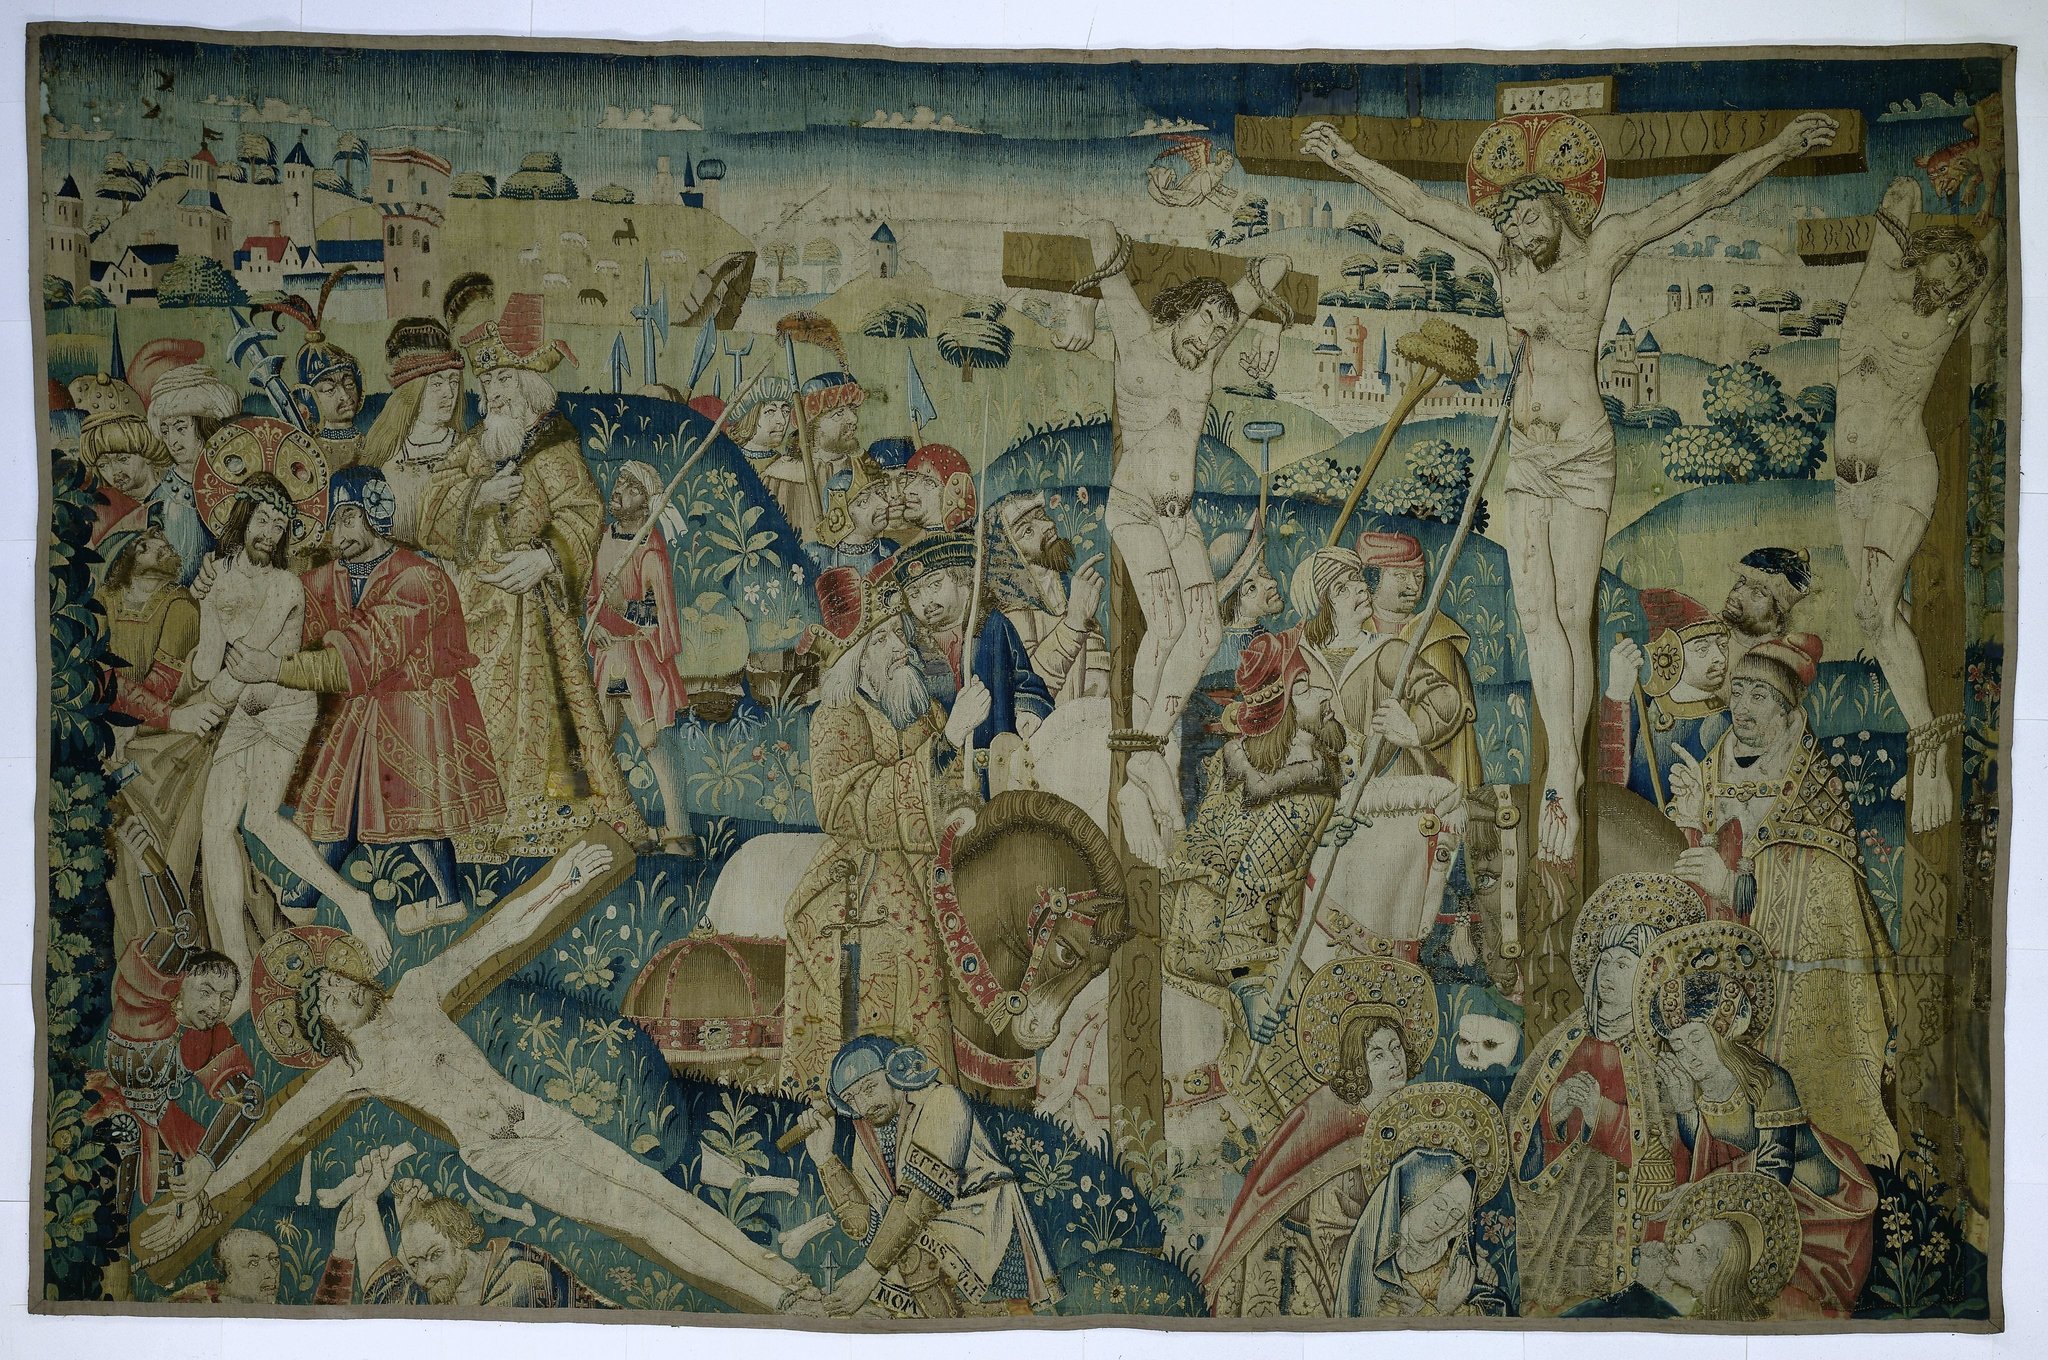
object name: tapestry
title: De kruisiging, uit de passie van Christus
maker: Anonymous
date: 1495-1505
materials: silk, wool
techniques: tapestry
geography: southern netherlands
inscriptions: inscription: ‘INRI’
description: Tapestry (fragment). The Passion: Christ Stripped of His Garments, Christ Nailed to the Cross, The Crucifixion. Wool, silk. Southern Netherlands (Tournai ?), c. 1475 - 1500.